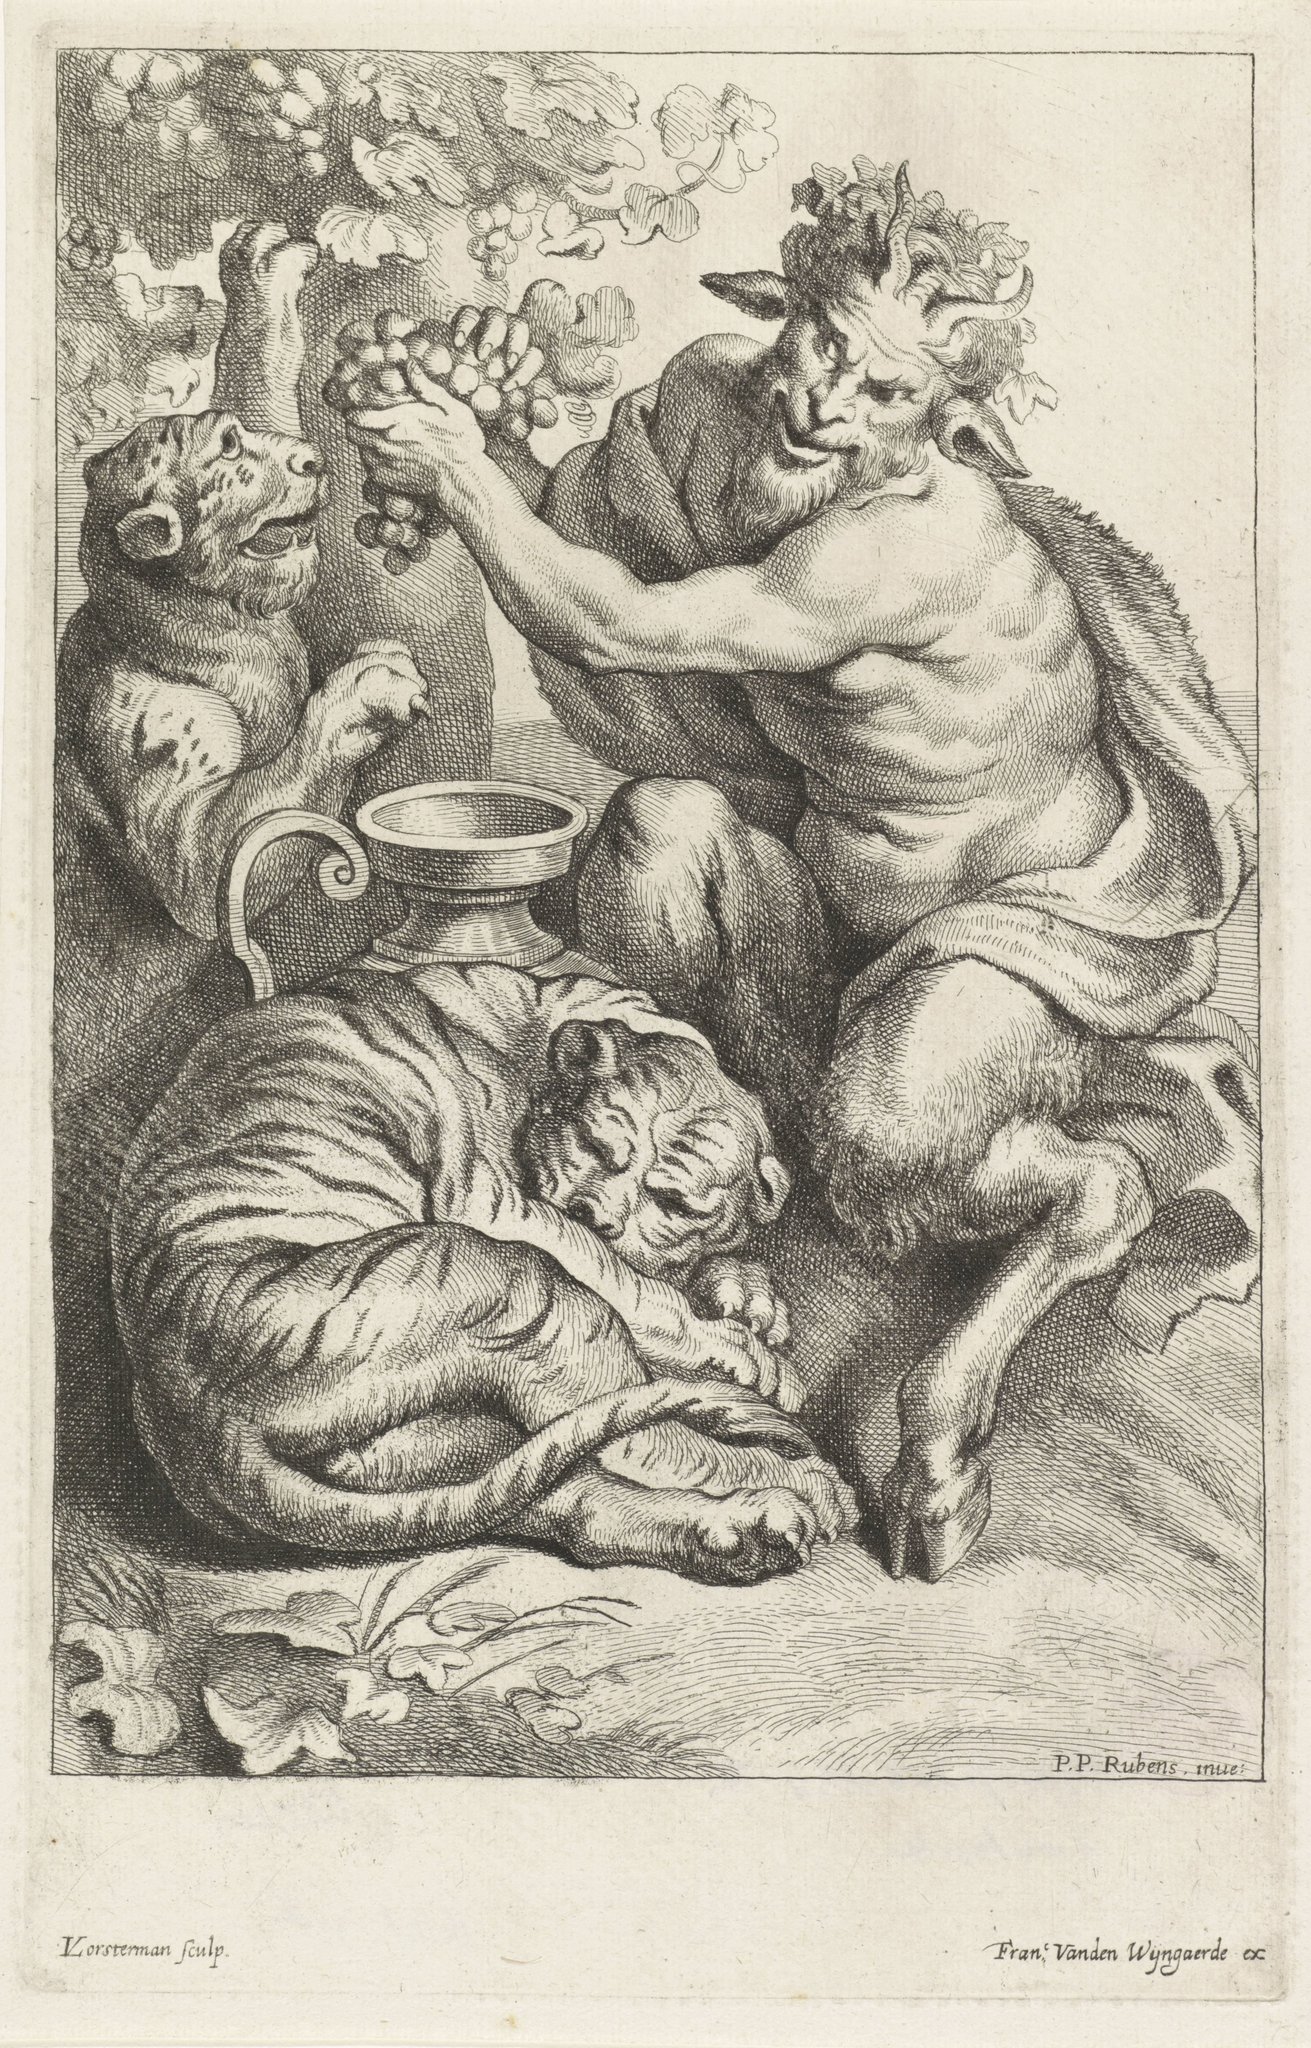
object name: print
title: Sater met een druiventros, een tijger en luipaard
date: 1651-1679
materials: paper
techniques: engraving, etching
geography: antwerp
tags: beasts of prey, predatory animals: tiger, beasts of prey, predatory animals: leopard, satyr(s) (in general), bunch of grapes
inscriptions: collector's mark: Lugt 240